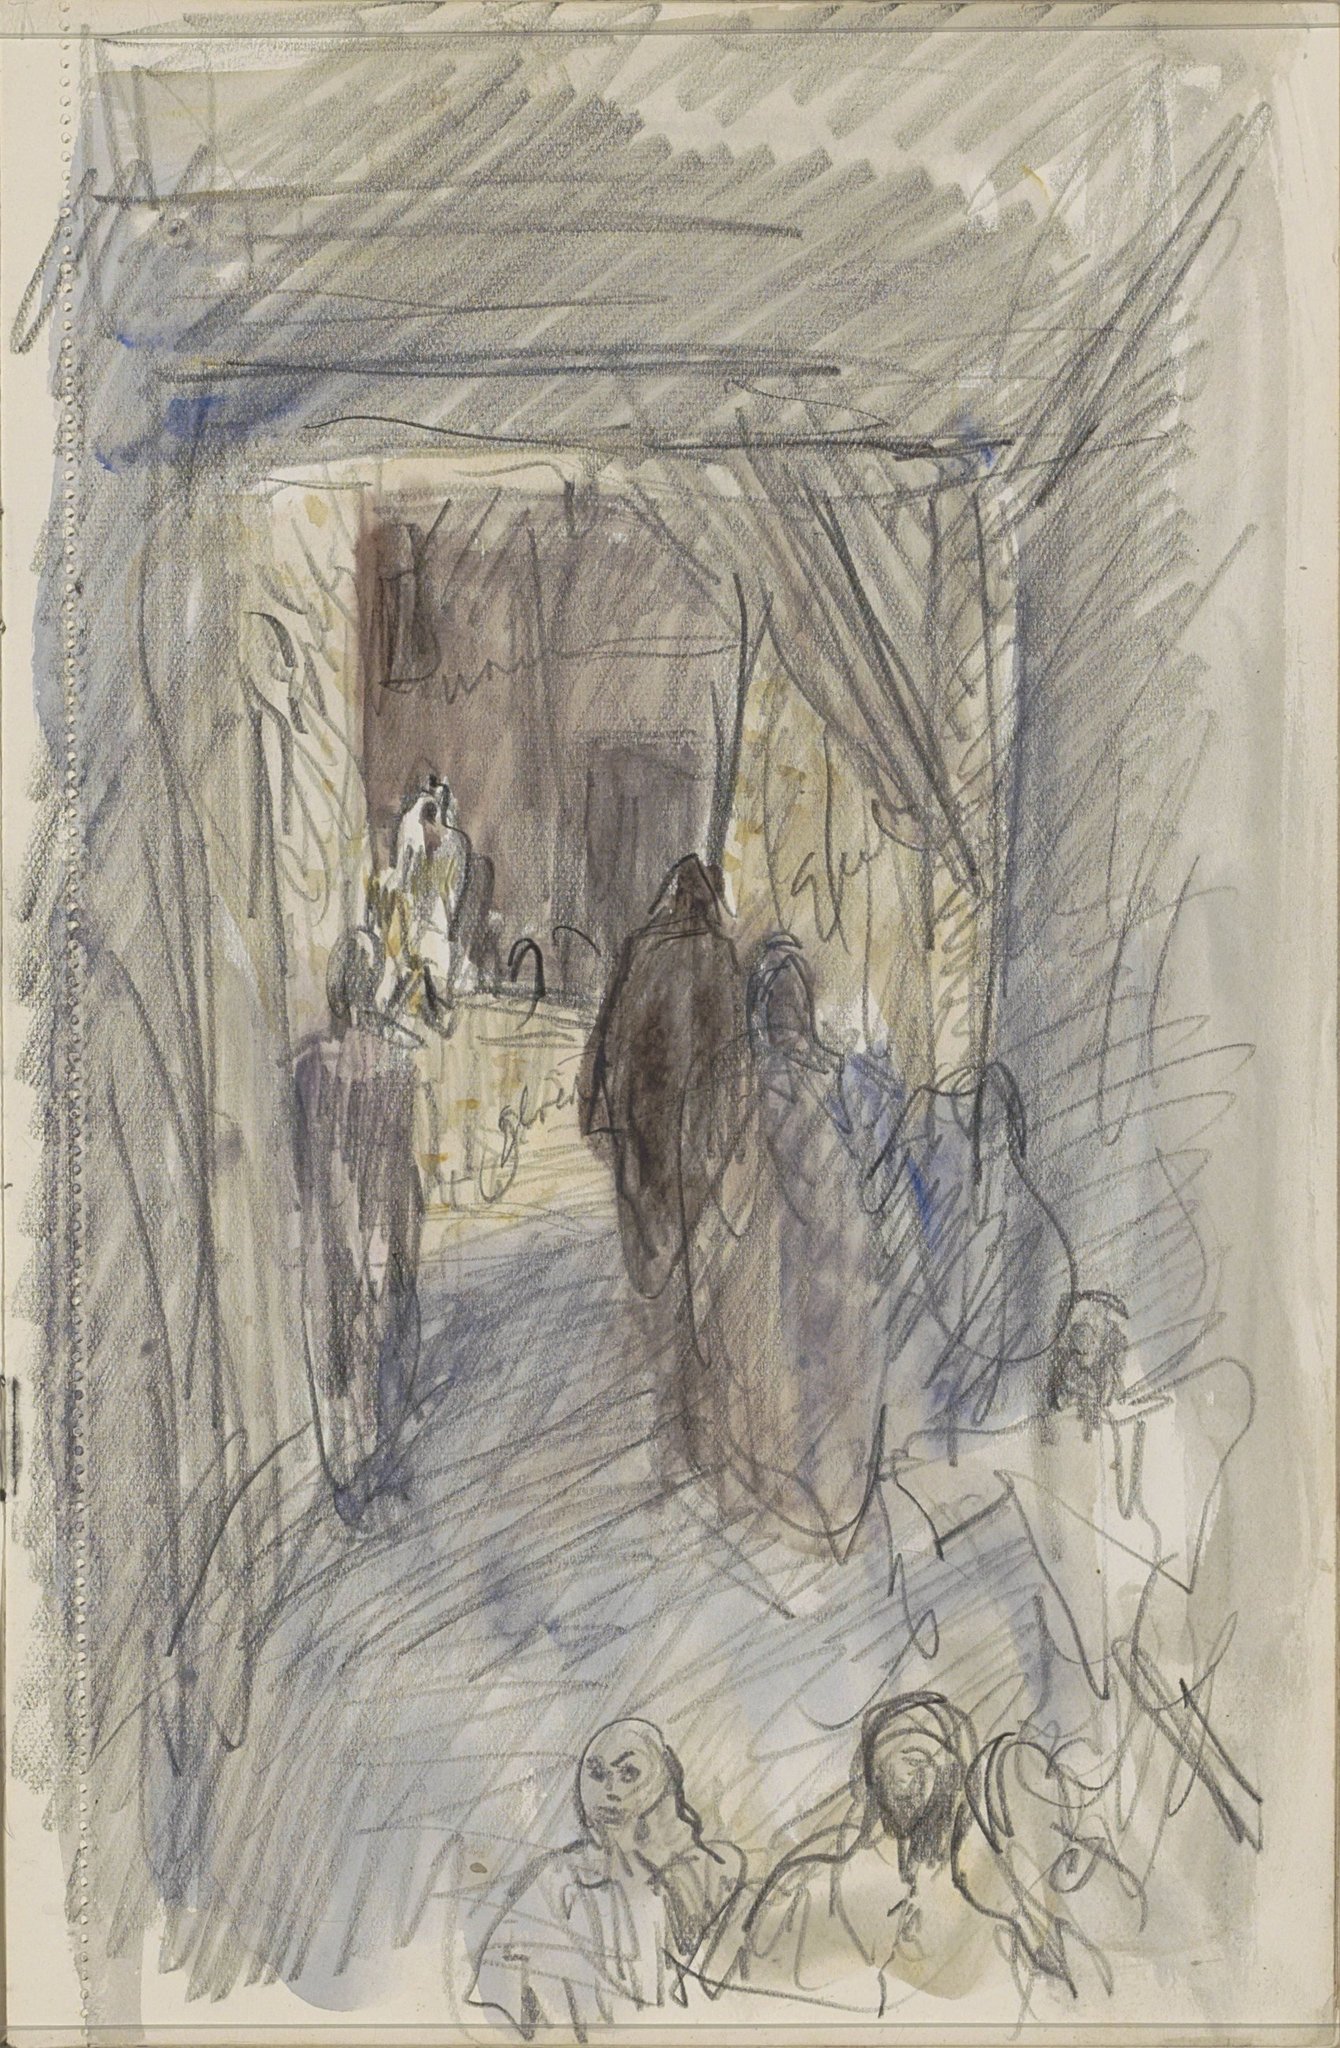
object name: sketchbook leaf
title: Overdekte straat met figuren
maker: marius bauer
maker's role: draughtsman, print maker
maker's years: 1867-1932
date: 1923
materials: paper, pencil, watercolor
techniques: brush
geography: morocco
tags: street (+ city(-scape) with figures, staffage)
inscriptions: kleurnotitie, handgeschreven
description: Pagina 65 uit een schetsboek met 66 bladen.